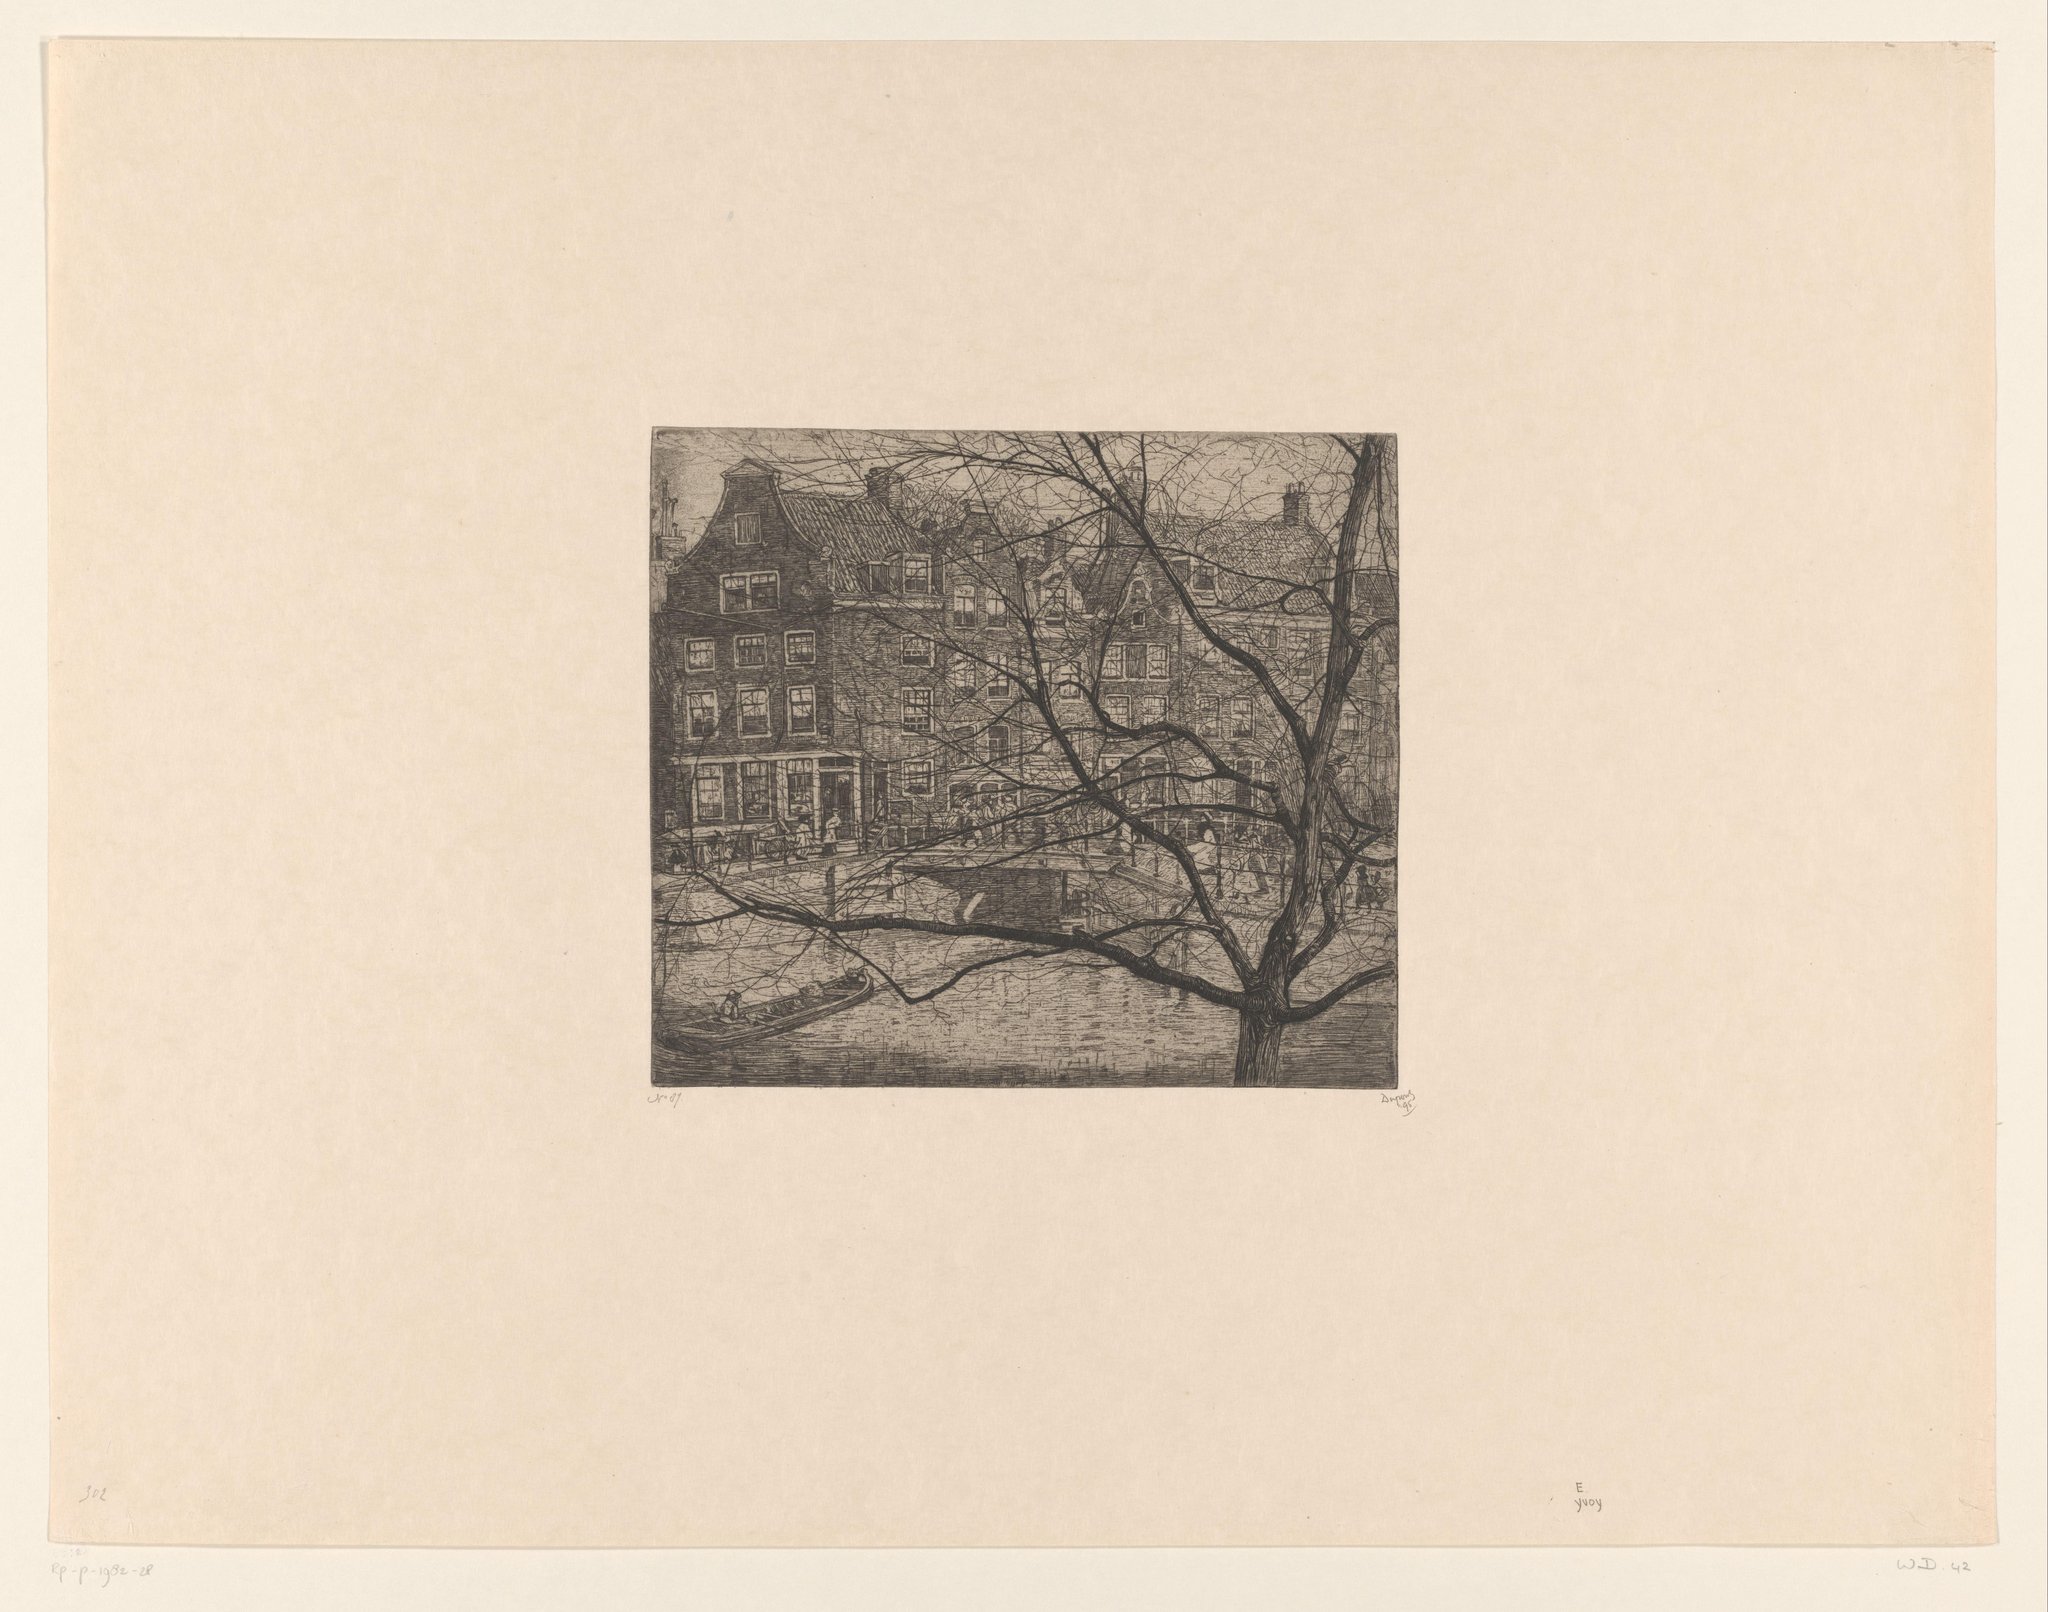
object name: print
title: Prinsengracht in Amsterdam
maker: pieter dupont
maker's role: draughtsman, print maker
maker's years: 1870-1911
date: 1895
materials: paper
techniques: etching, intaglio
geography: amsterdam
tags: trees, bridge in city across river, canal, etc.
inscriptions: collector's mark: Lugt 2228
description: Gezicht op de prinsengracht in Amsterdam. Op de voorgrond een boom.